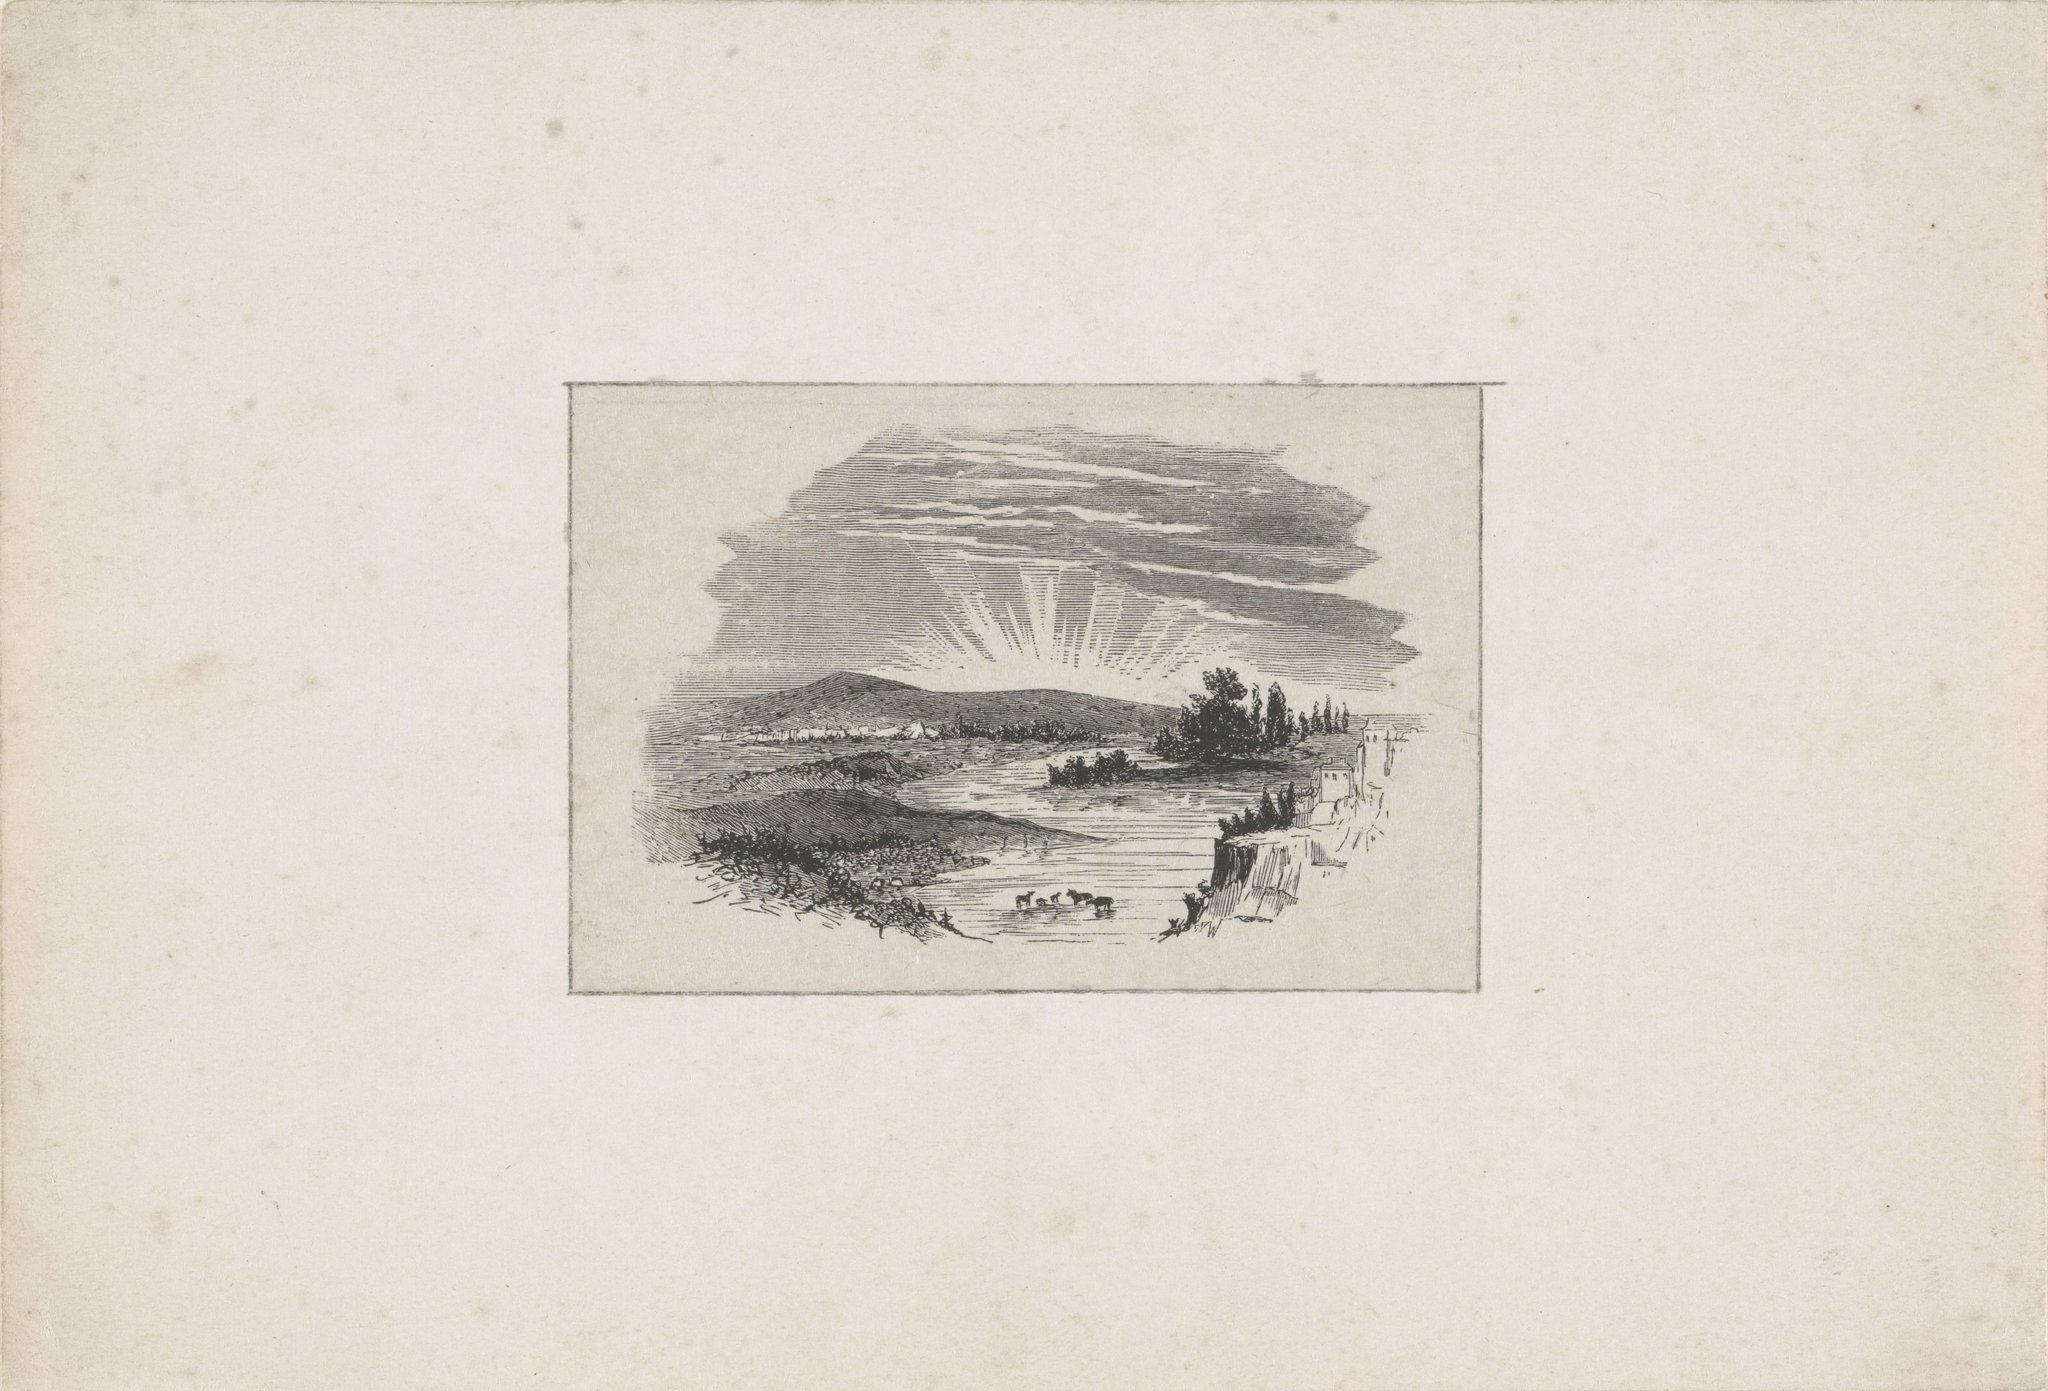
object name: print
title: Heuvellandschap met dieren in het water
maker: isaac weissenbruch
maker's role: print maker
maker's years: 1826-1912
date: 1836-1912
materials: paper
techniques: engraving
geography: netherlands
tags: low hill country, animals, water course